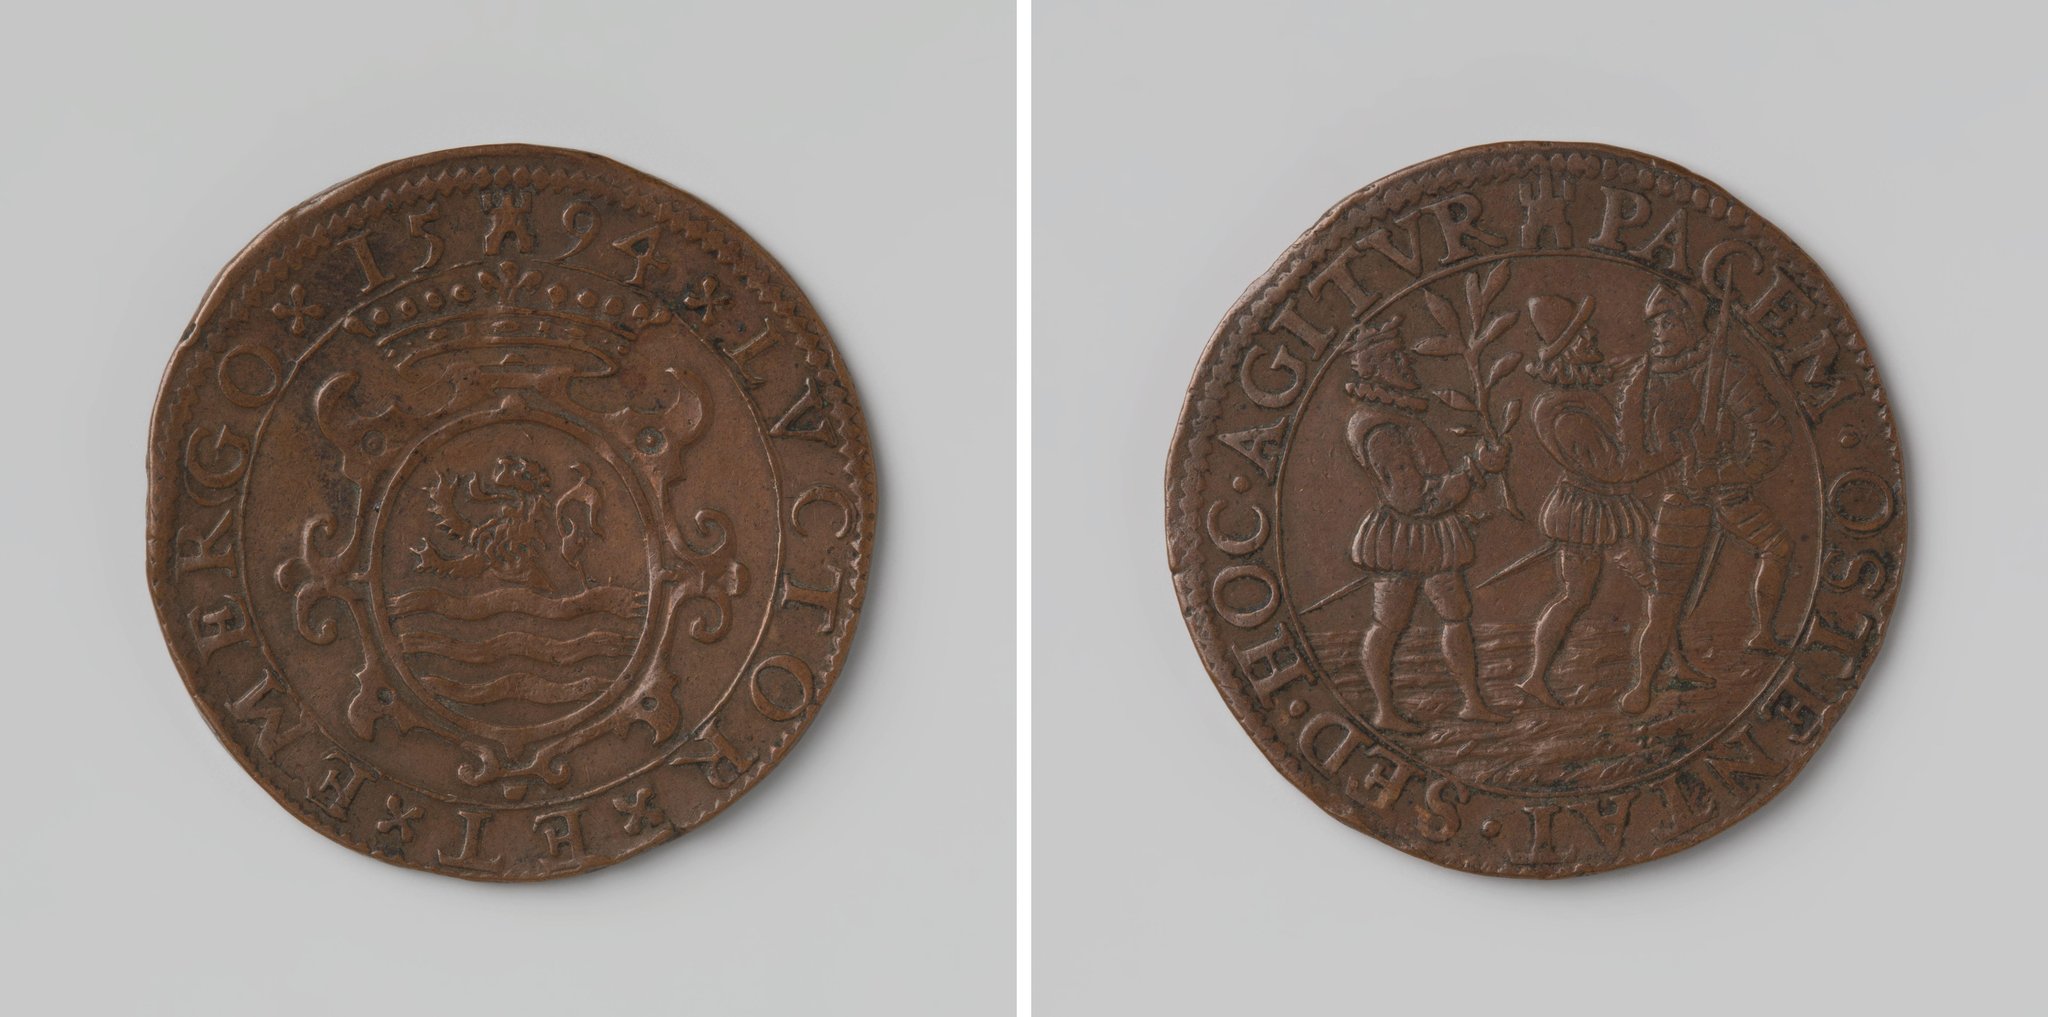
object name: jeton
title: Afwijzing door de Staten-Generaal van de vredesvoorstellen van Ernst, aartshertog van Oostenrijk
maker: Anonymous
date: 1594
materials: copper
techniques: striking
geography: middelburg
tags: philip ii of spain, vienna, brussels, zeeland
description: Koperen penning. Voorzijde: gekroond wapenschild in cartouche binnen omschrift. Keerzijde: Filips II biedt een Nederlander de vredestak aan, terwijl een Spaanse soldaat hem probeert te ontwapenen binnen omschrift